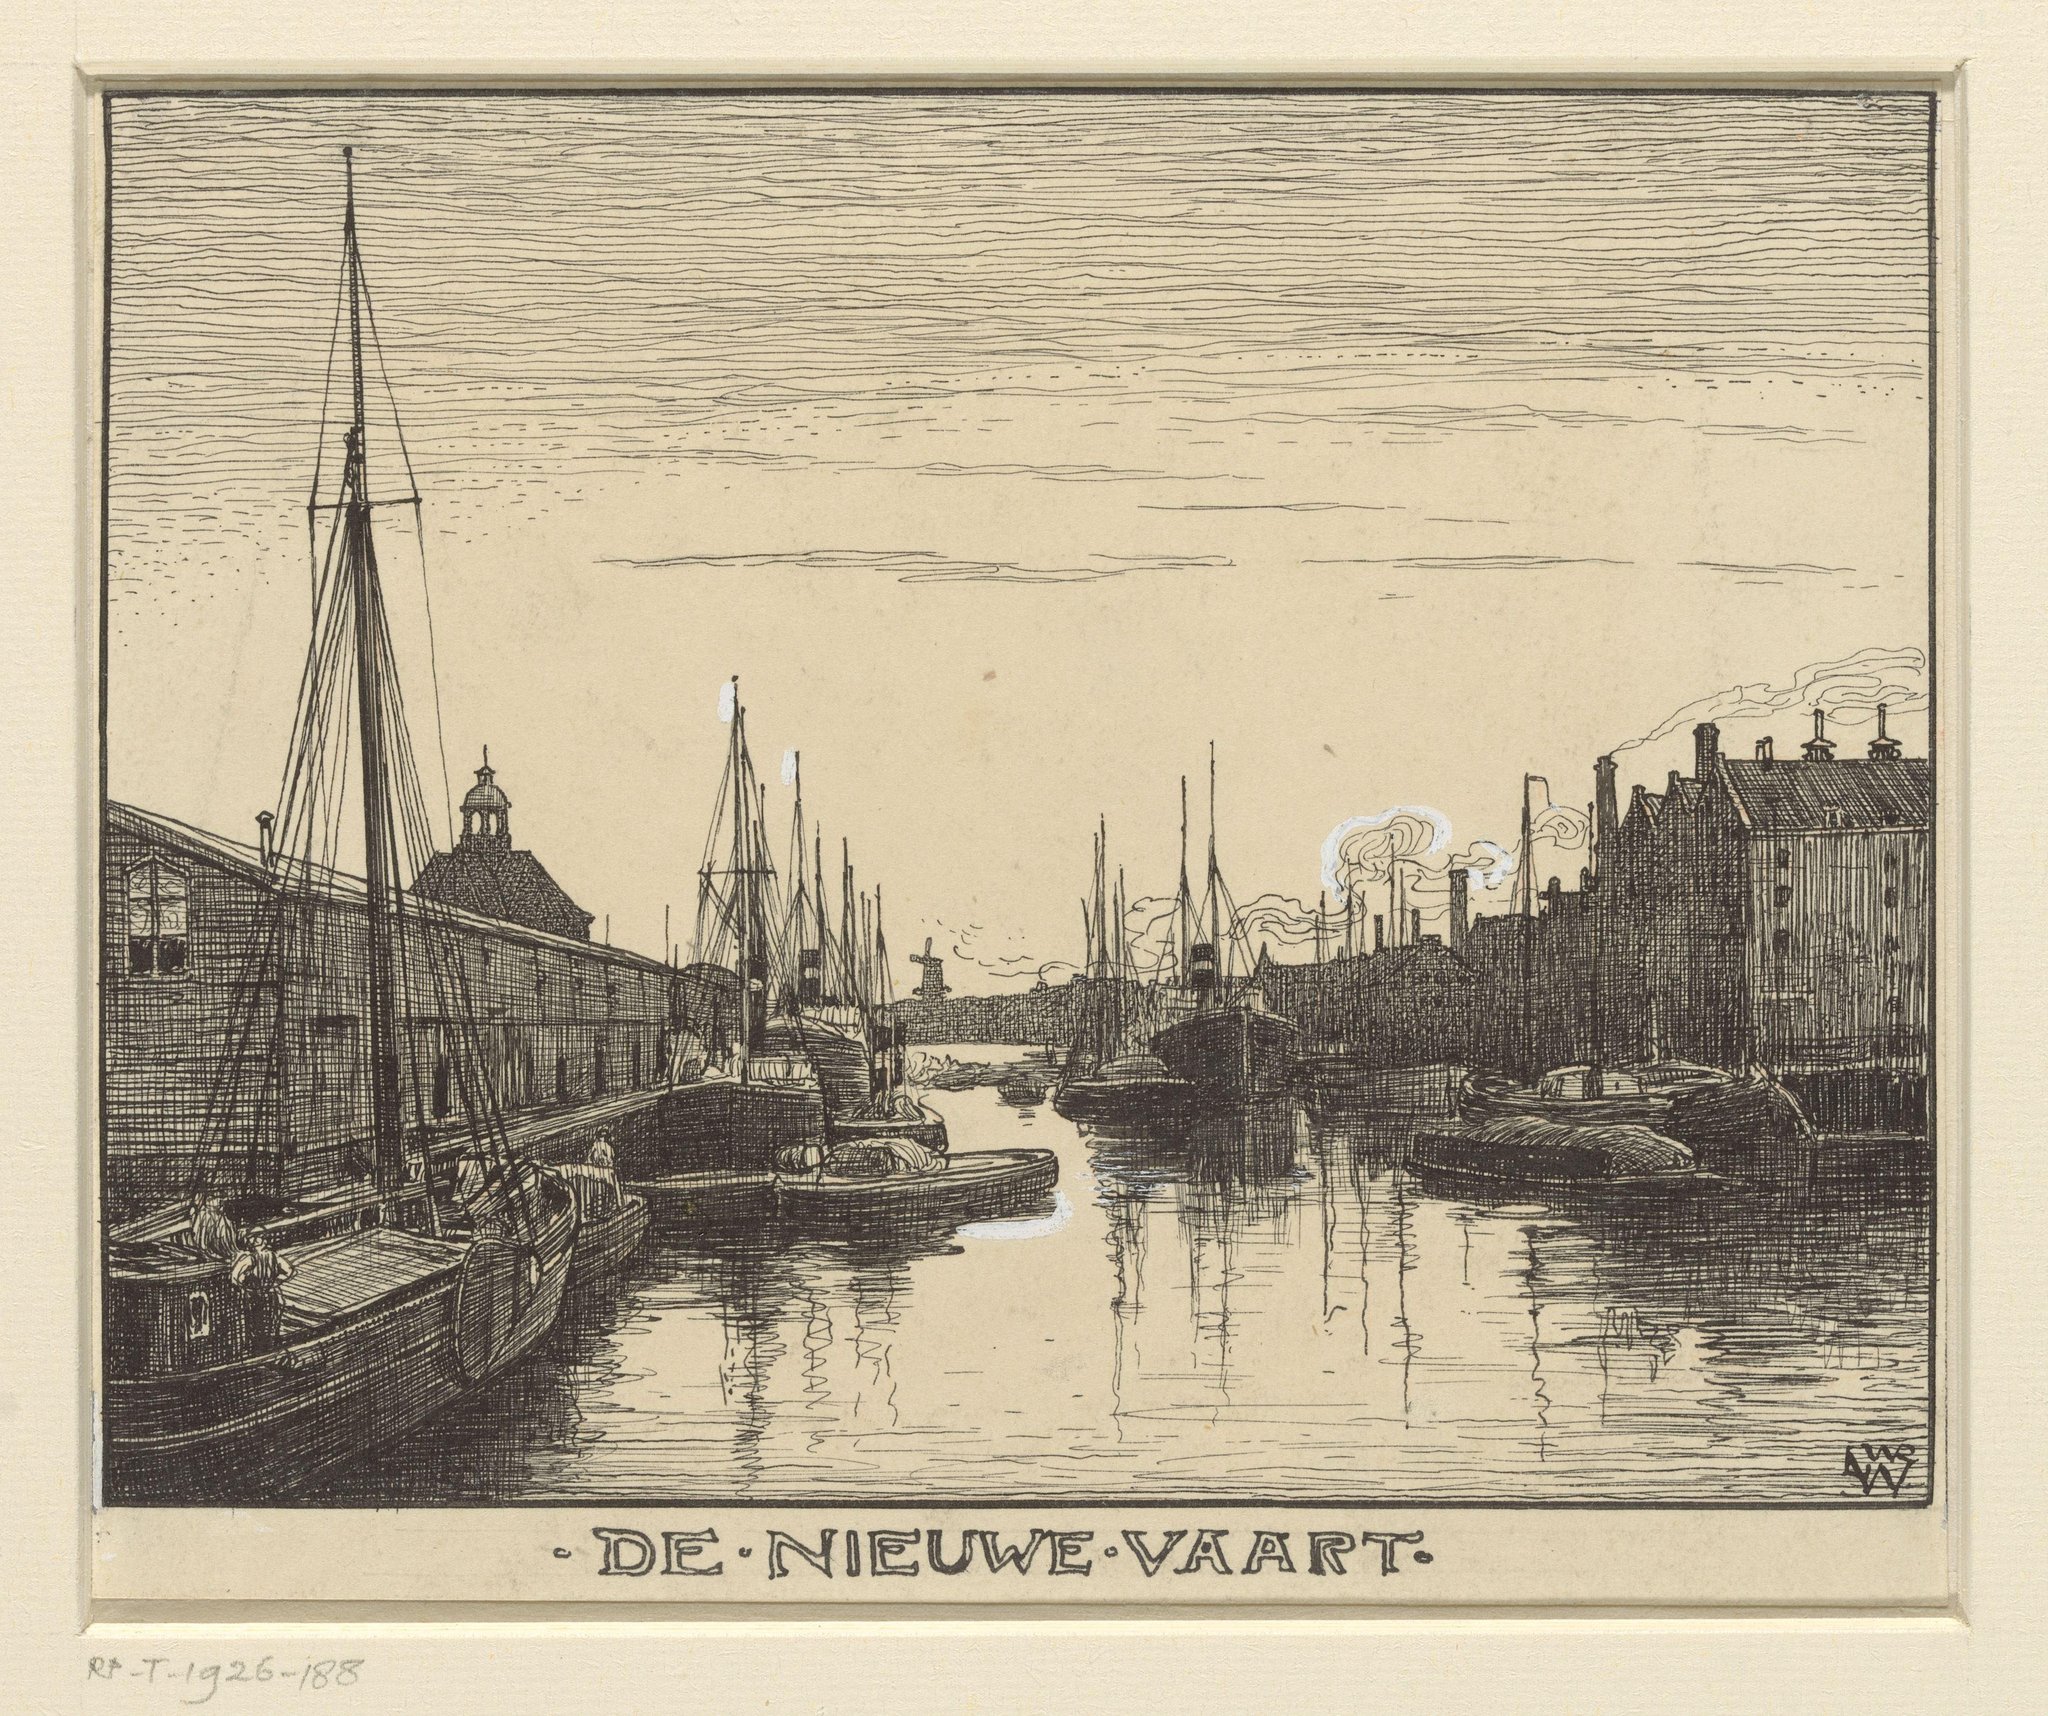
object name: drawing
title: De Nieuwe Vaart te Amsterdam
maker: willem wenckebach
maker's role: designer, draughtsman, painter, print maker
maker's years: 1860-1937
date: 1870-1926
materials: paint, ink, paper, pencil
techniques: pen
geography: amsterdam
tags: canals, waters (in city)